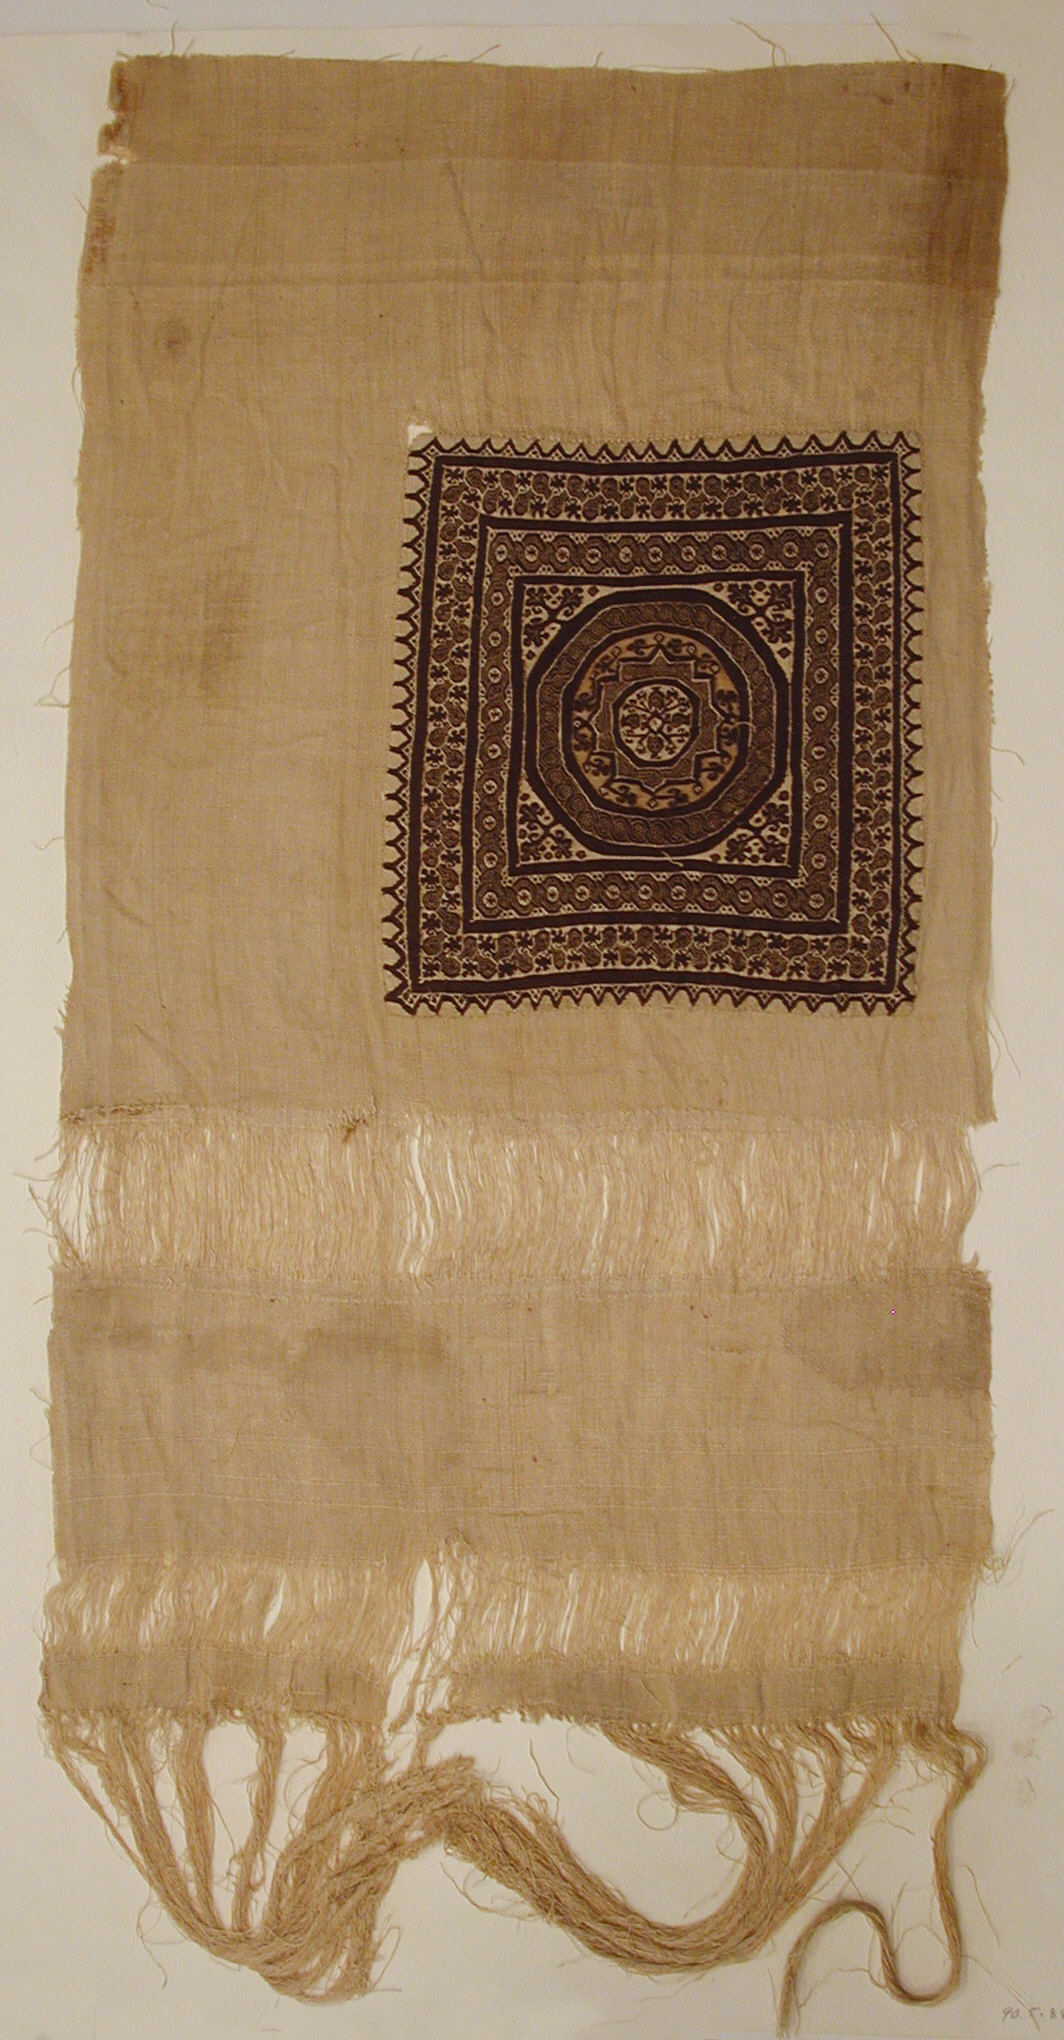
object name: textile fragment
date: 201-400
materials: linen, wool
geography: egypt